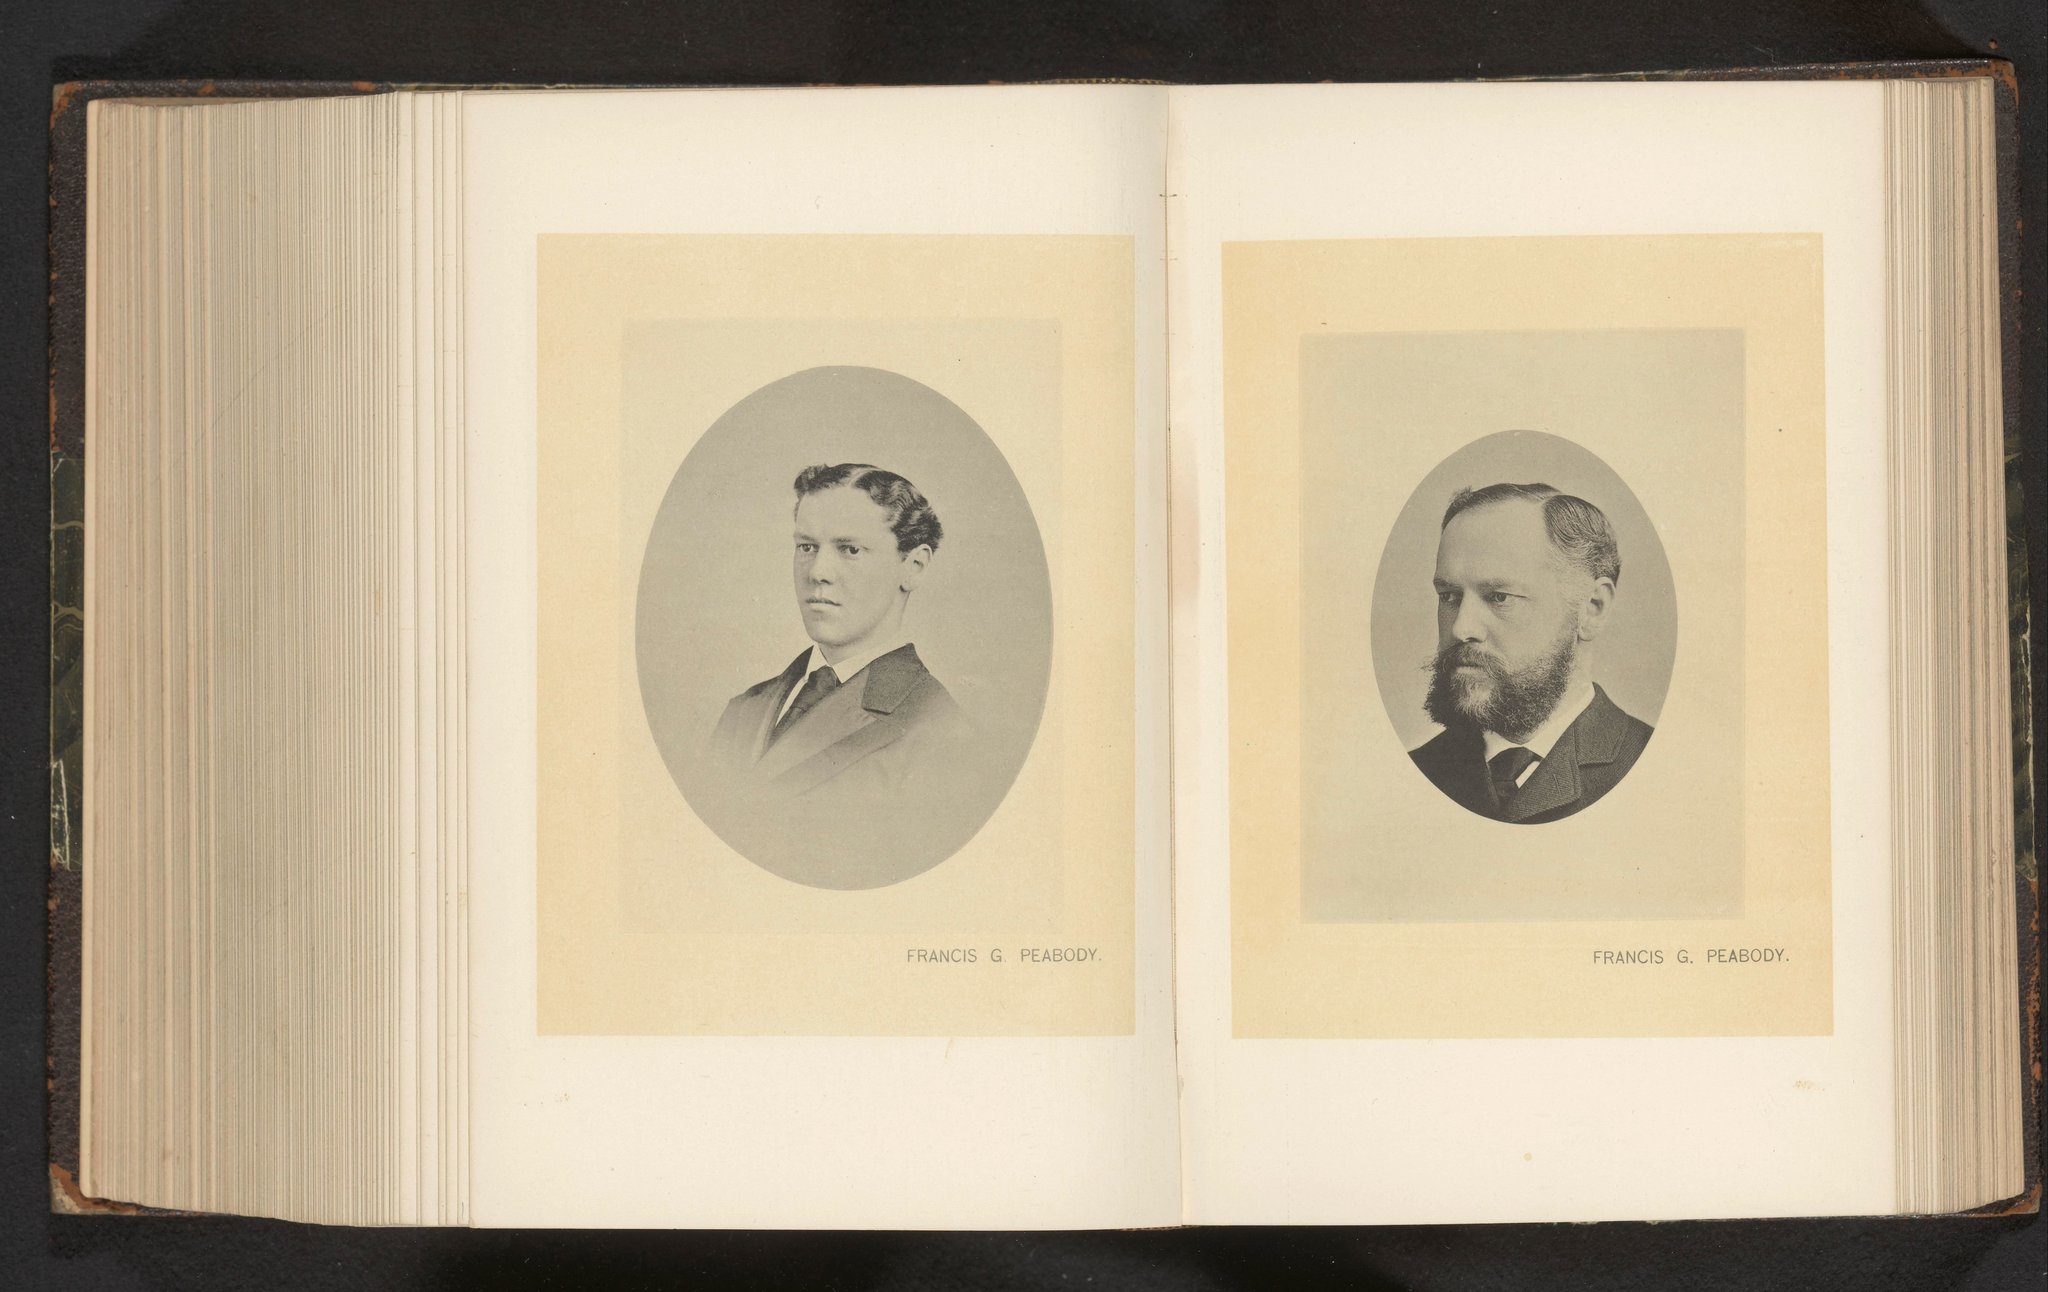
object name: photomechanical print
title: Francis G. Peabody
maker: Anonymous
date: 1869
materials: paper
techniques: photoaquatint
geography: boston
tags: adult man